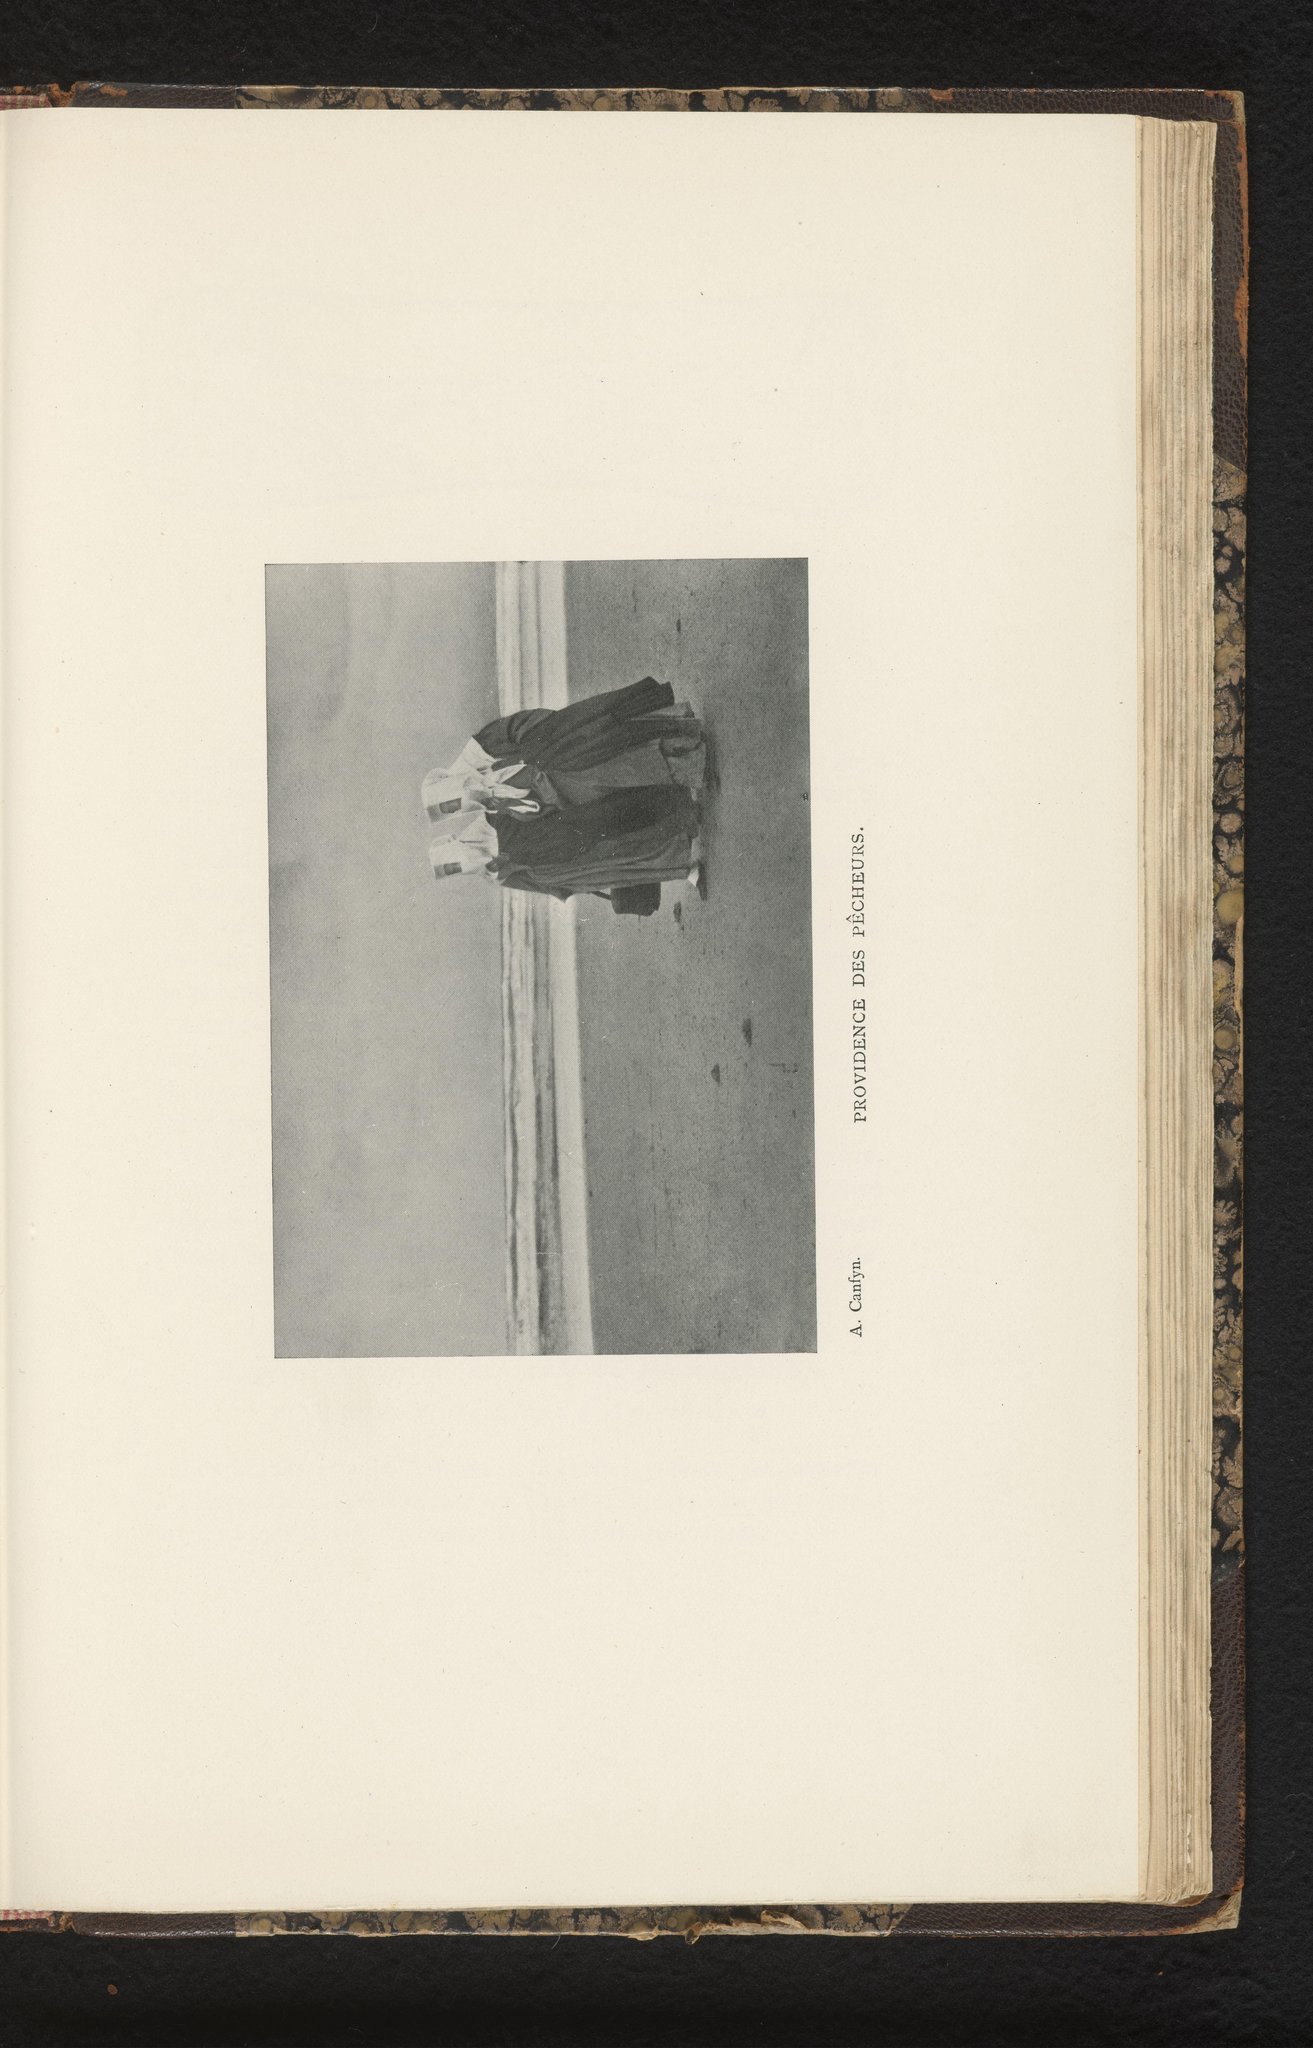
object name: page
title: Providence des pêcheurs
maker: albert canfyn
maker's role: fotograaf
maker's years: 1861-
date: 1897-1902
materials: paper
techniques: autotype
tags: nun(s), coast